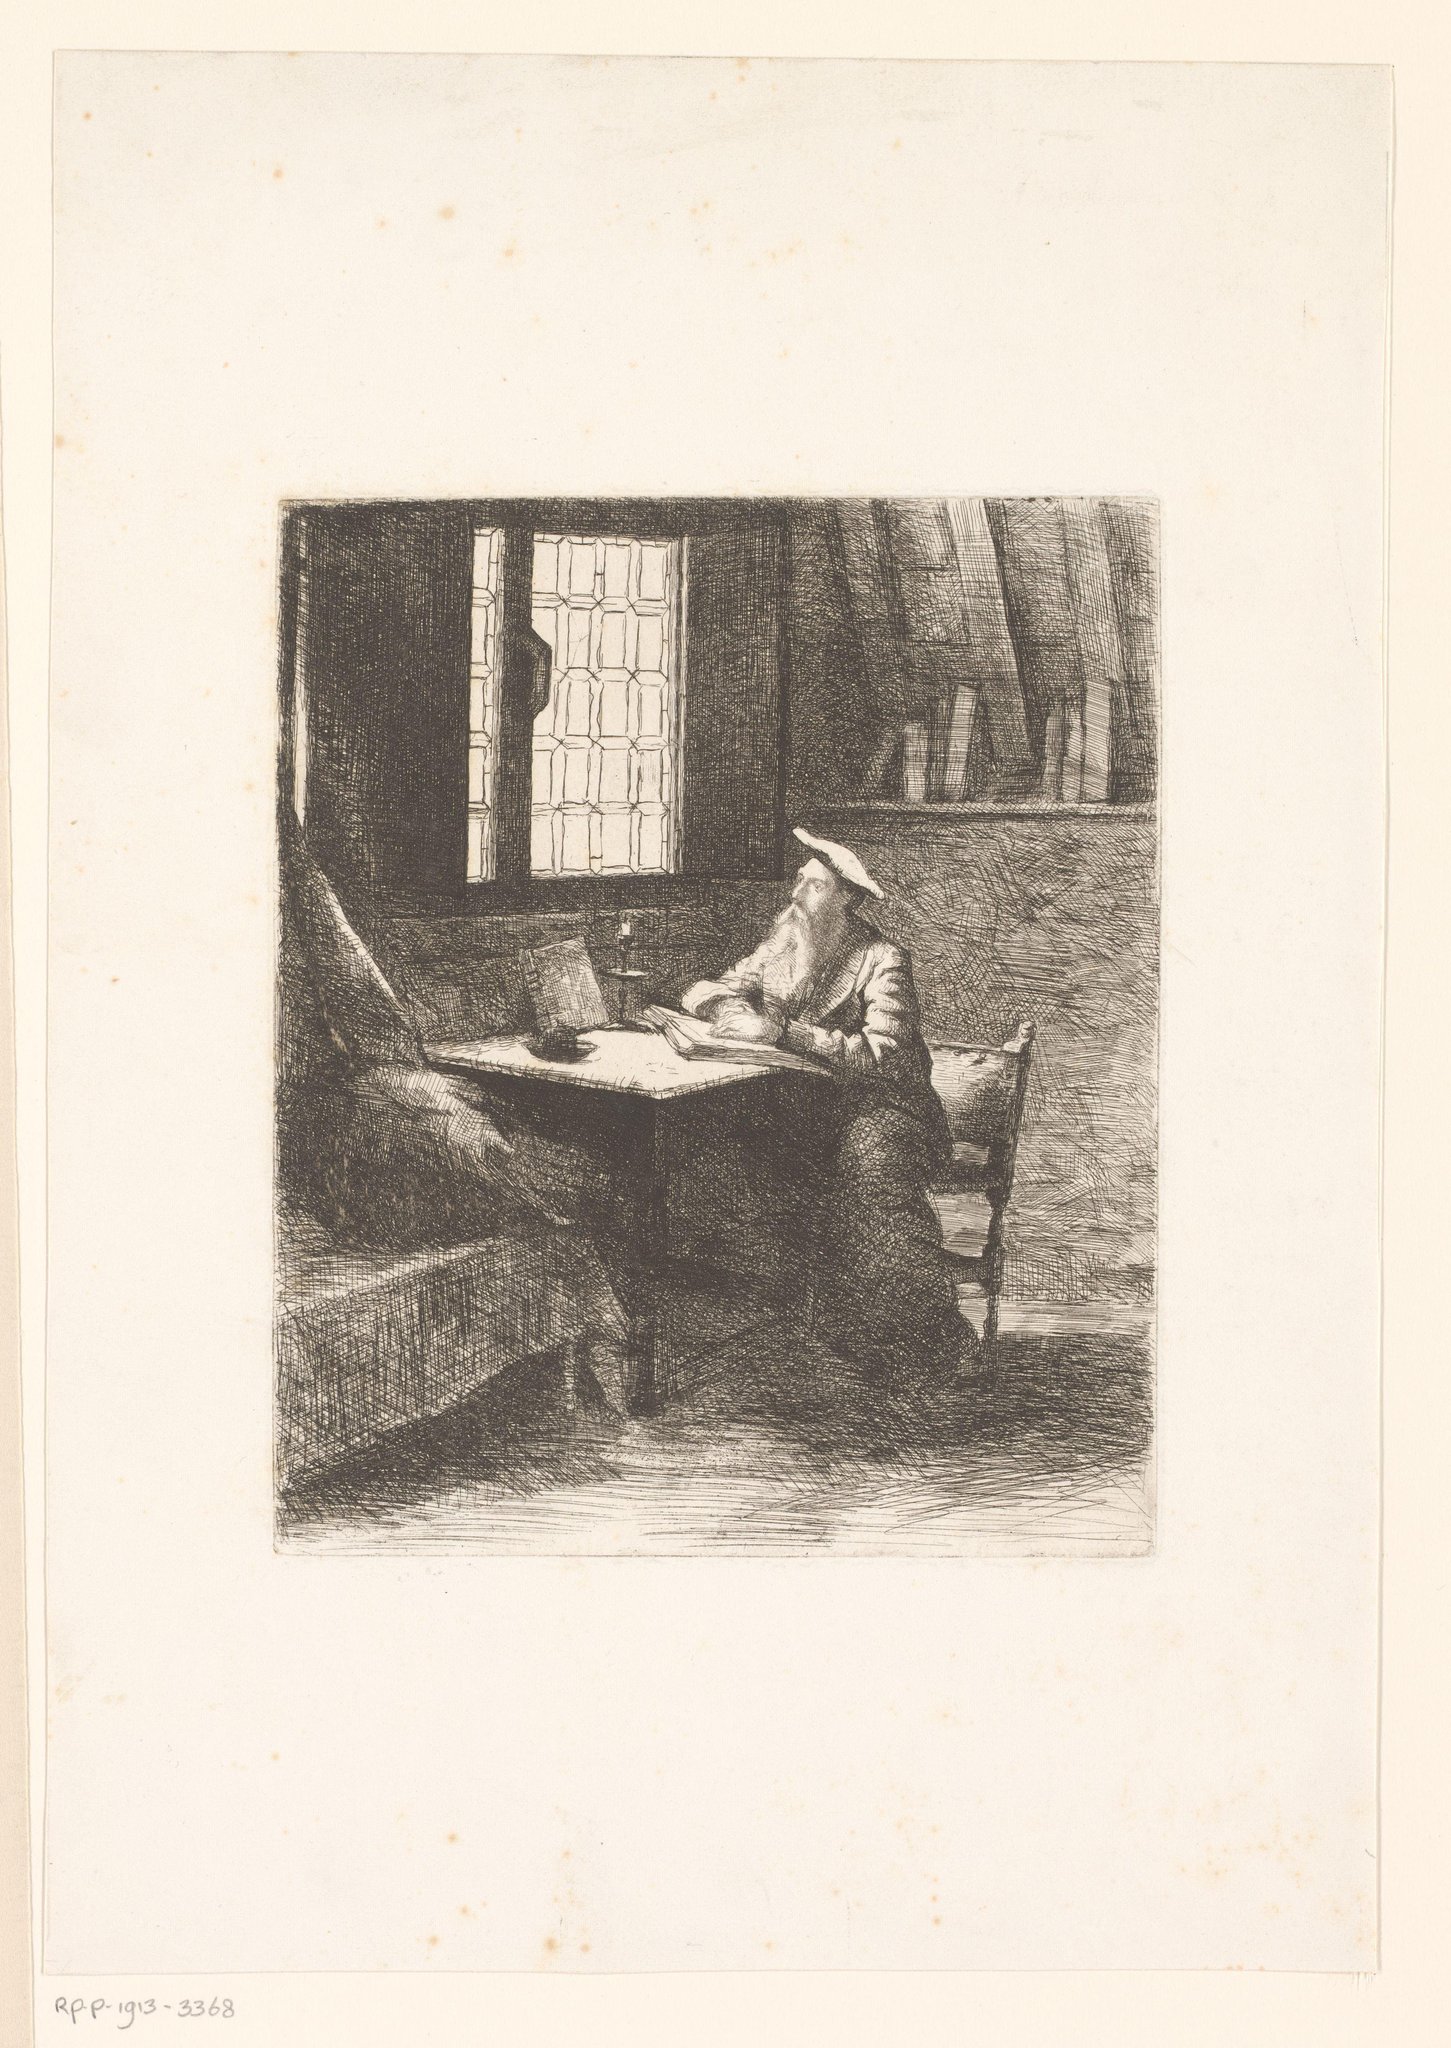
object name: print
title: Man zit aan tafel met een opengeslagen boek en kijkt door een raam naar buiten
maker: piet verhaert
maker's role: print maker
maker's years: 1852-1908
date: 1879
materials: paper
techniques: etching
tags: book - mm - book open, table, old man, beard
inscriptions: collector's mark: Lugt 2228